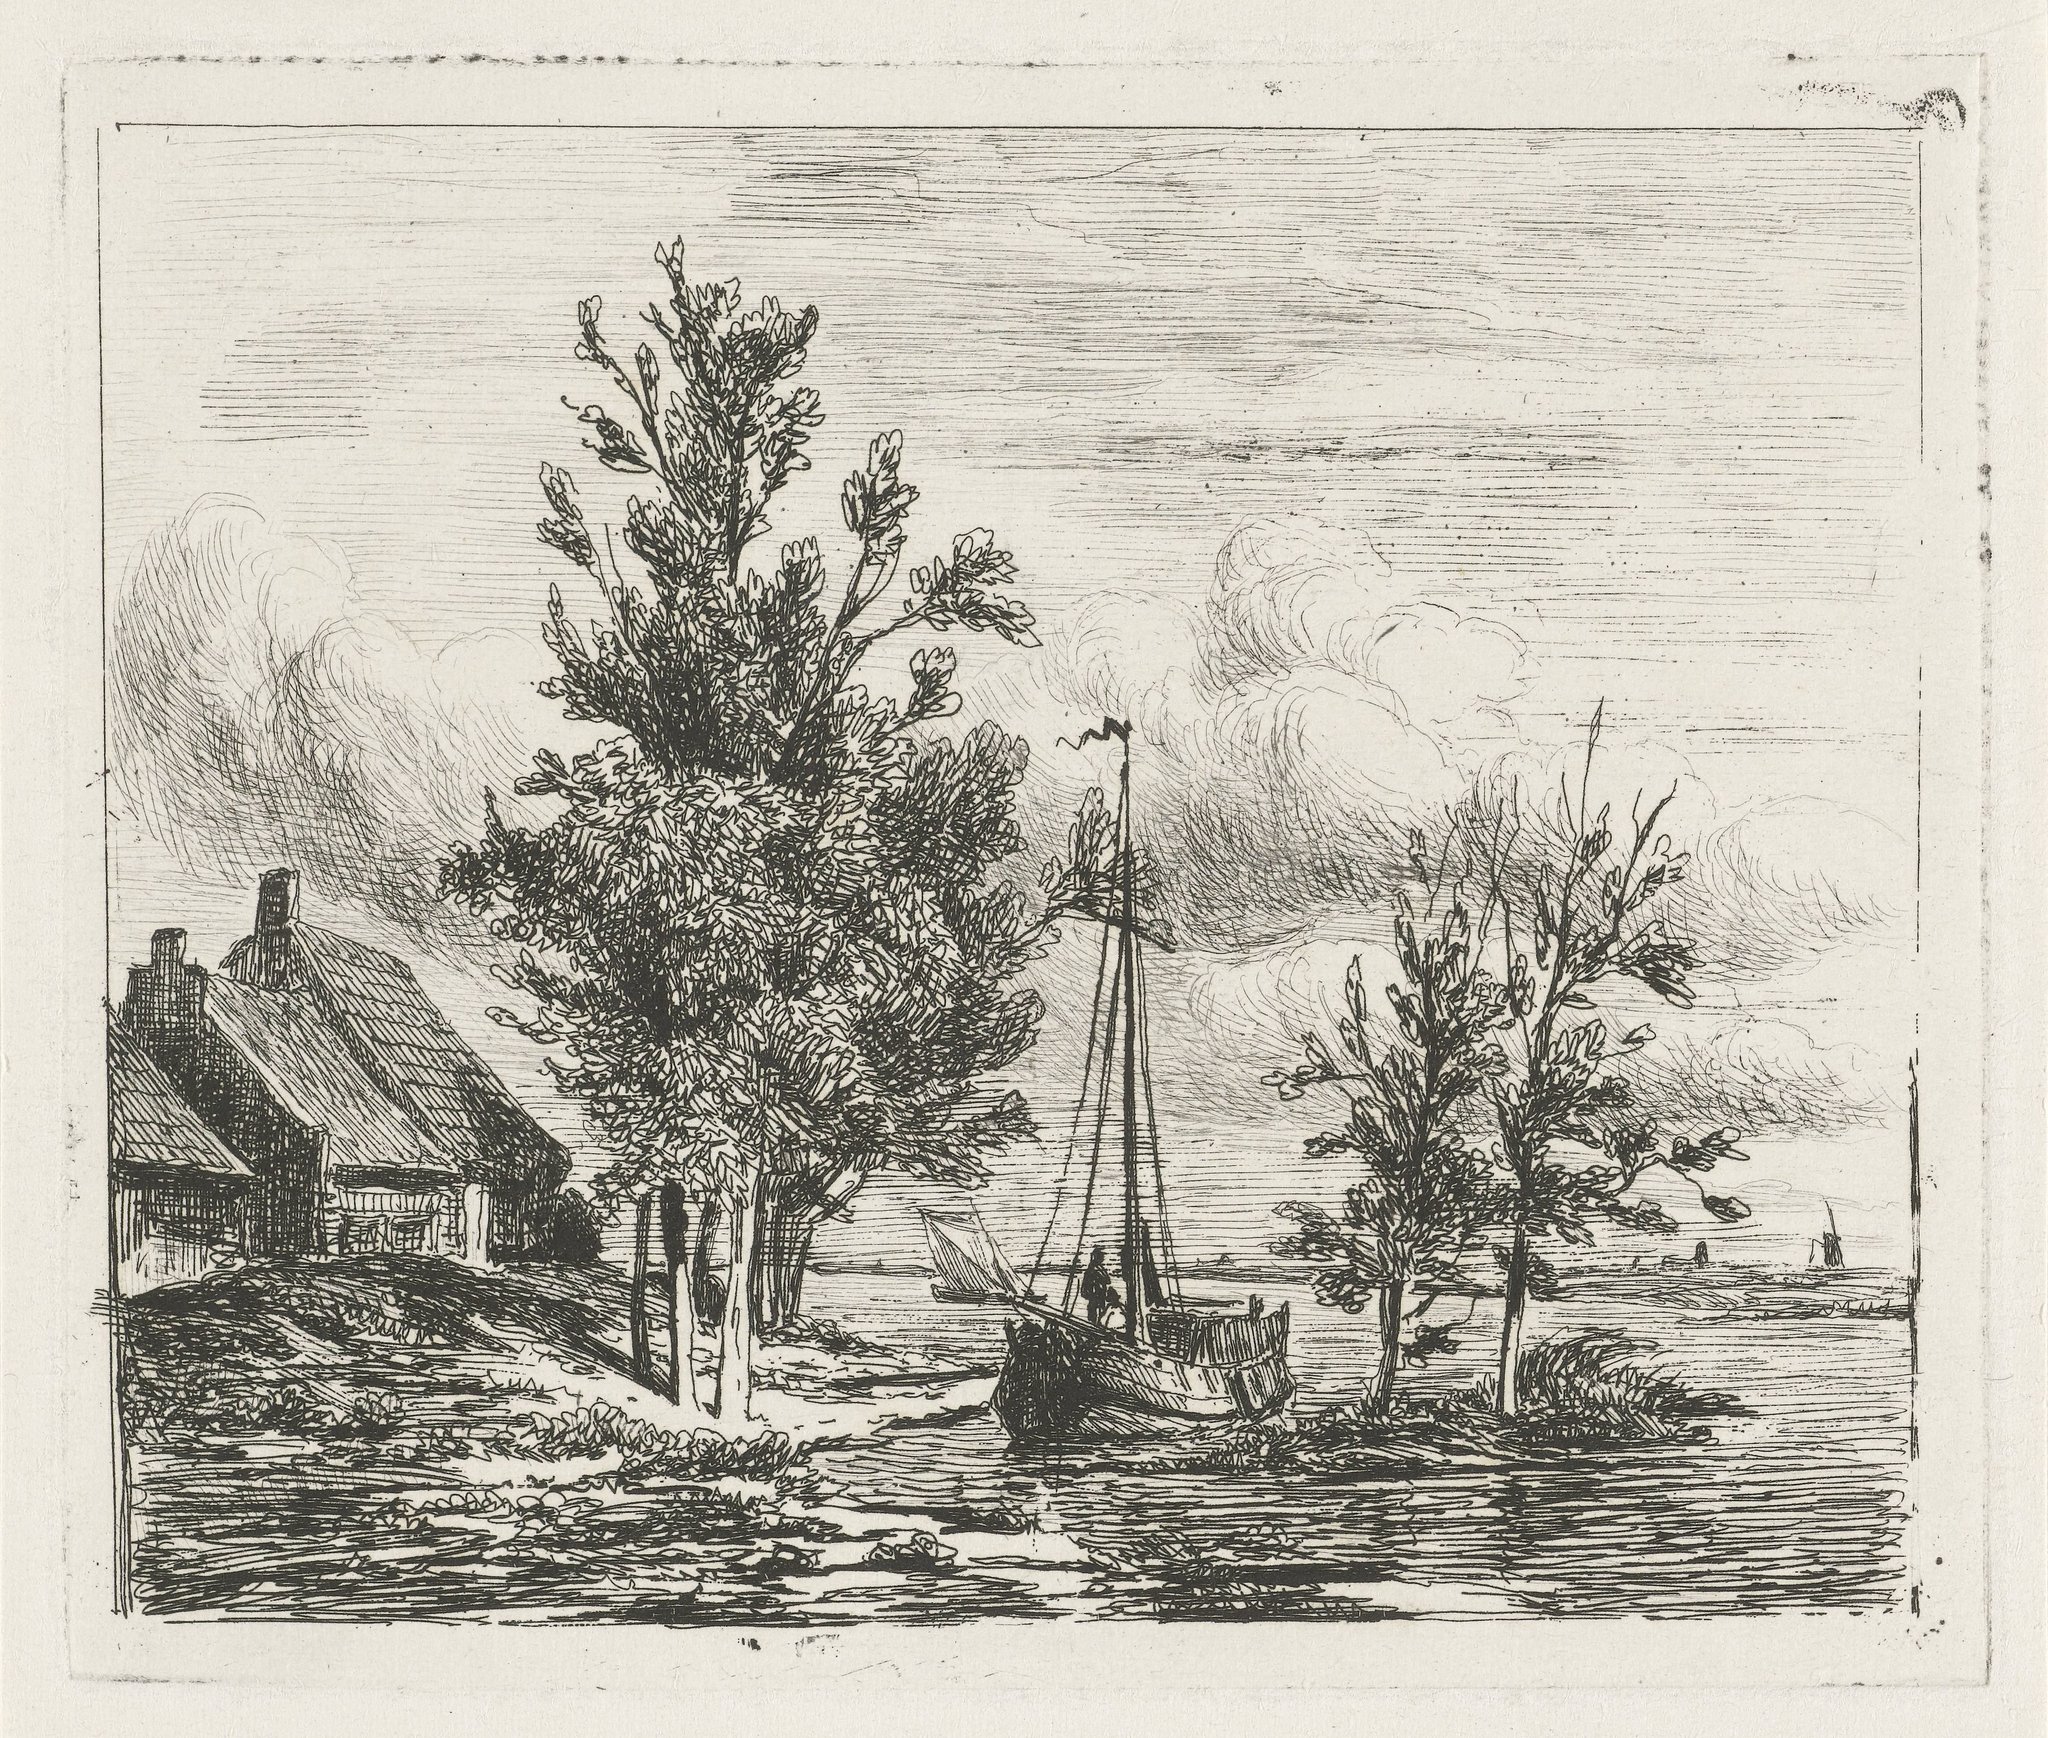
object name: print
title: Rivierlandschap met zeilschip en boerderij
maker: lambertus hardenberg (1822-1900)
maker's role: draughtsman, painter, print maker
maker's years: 1822-1900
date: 1837-1900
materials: paper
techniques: etching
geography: the hague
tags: sailing-ship, sailing-boat, river (+ landscape with figures, staffage), farm or solitary house in landscape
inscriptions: collector's mark: Lugt 2228